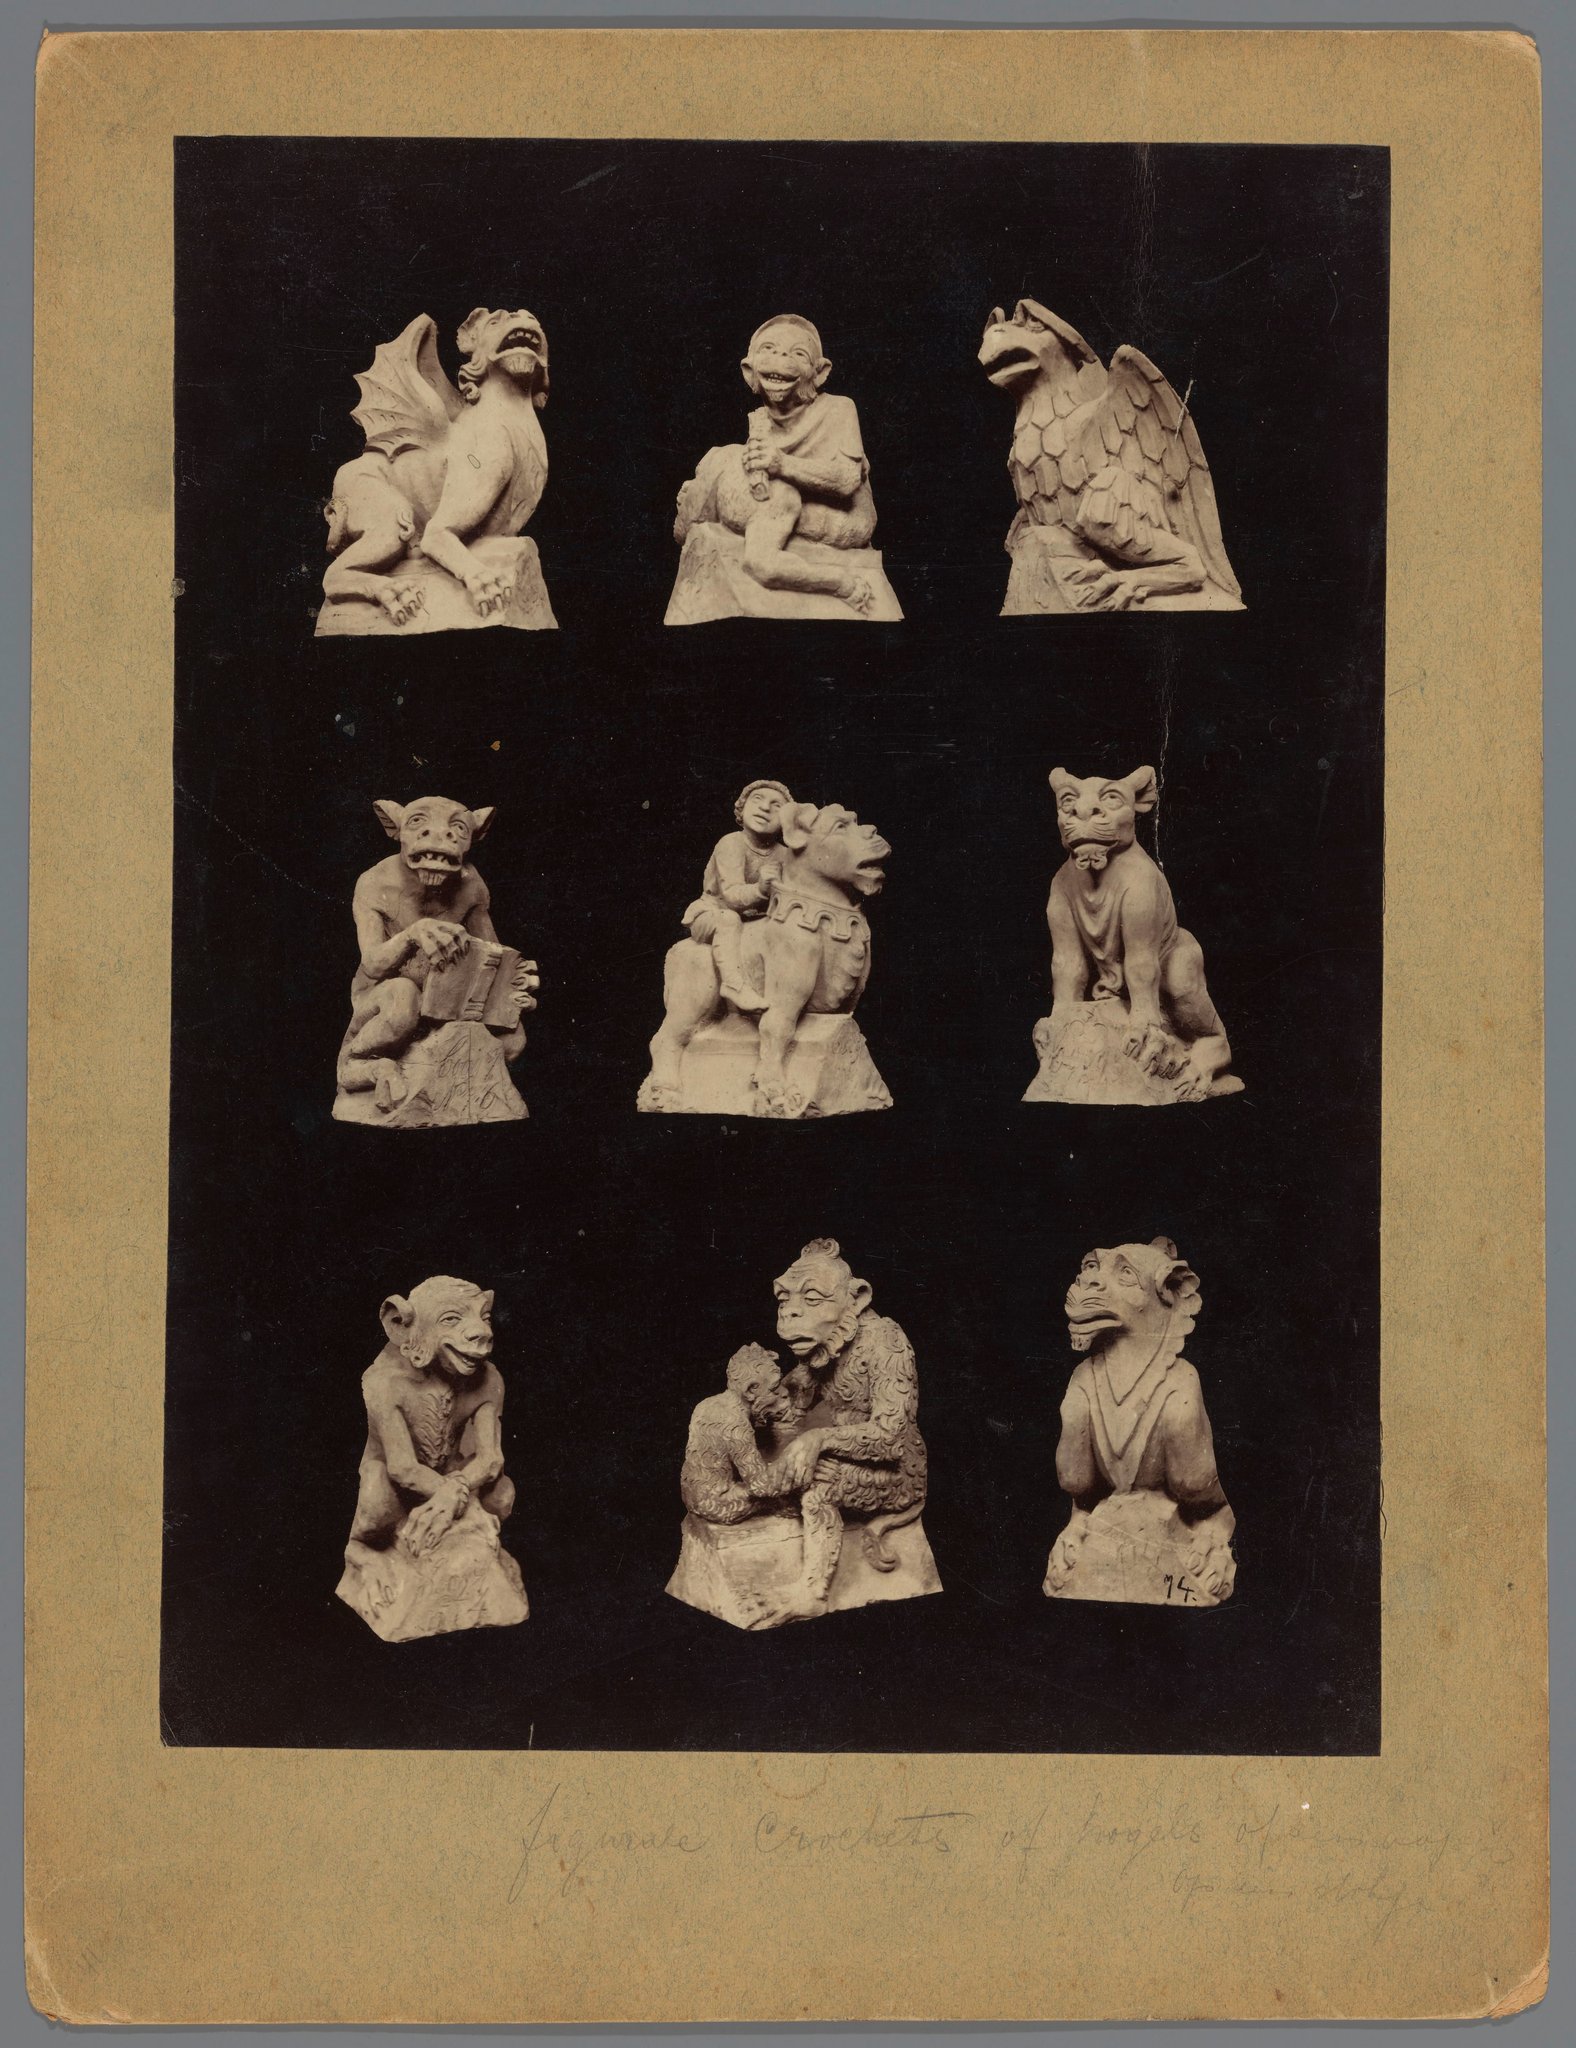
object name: photograph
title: Negen luchtboogfiguren van de Sint-Janskathedraal te 's-Hertogenbosch in de vorm van dieren en een man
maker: Anonymous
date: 1875-1900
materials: cardboard, photographic support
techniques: albumen print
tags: fabulous animals (sometimes wrongly called 'grotesques'); 'mostri' (ripa), animals, monkeys, apes, dragon, sculpture, beasts of prey, predatory animals: lion, dog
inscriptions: inscription: ‘figurate crockets of hogels of een aapje op een stokje’, name: ‘Kunstboekhandel J. A. G. de Leur photograaf-uitgever Huigenspark 40b. Den Haag.’, collector's mark: Lugt 3937